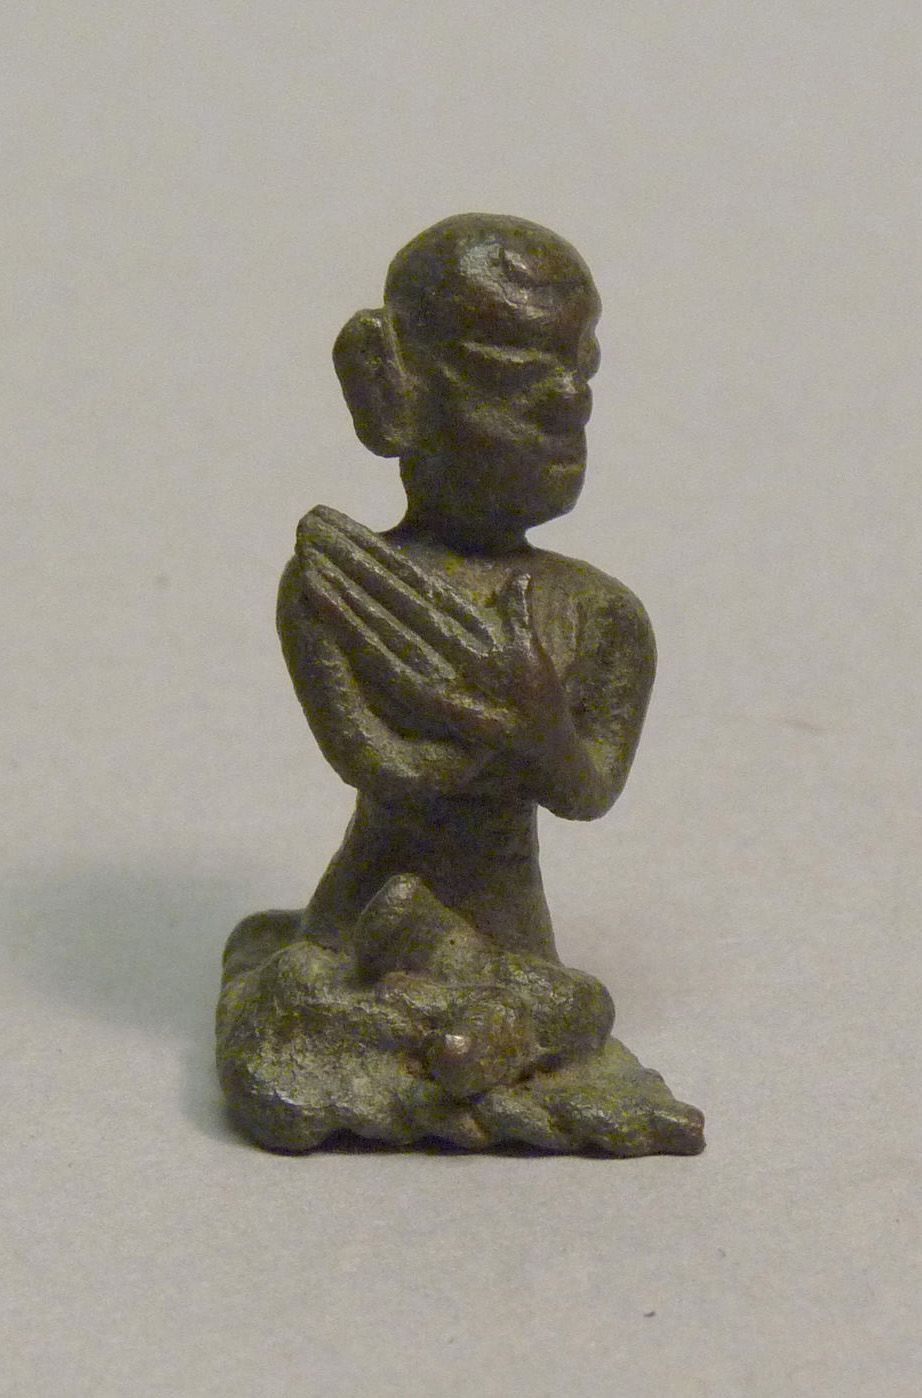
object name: figure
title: Squatting Figure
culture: indonesian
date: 500 BCE-300 CE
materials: bronze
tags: human figures